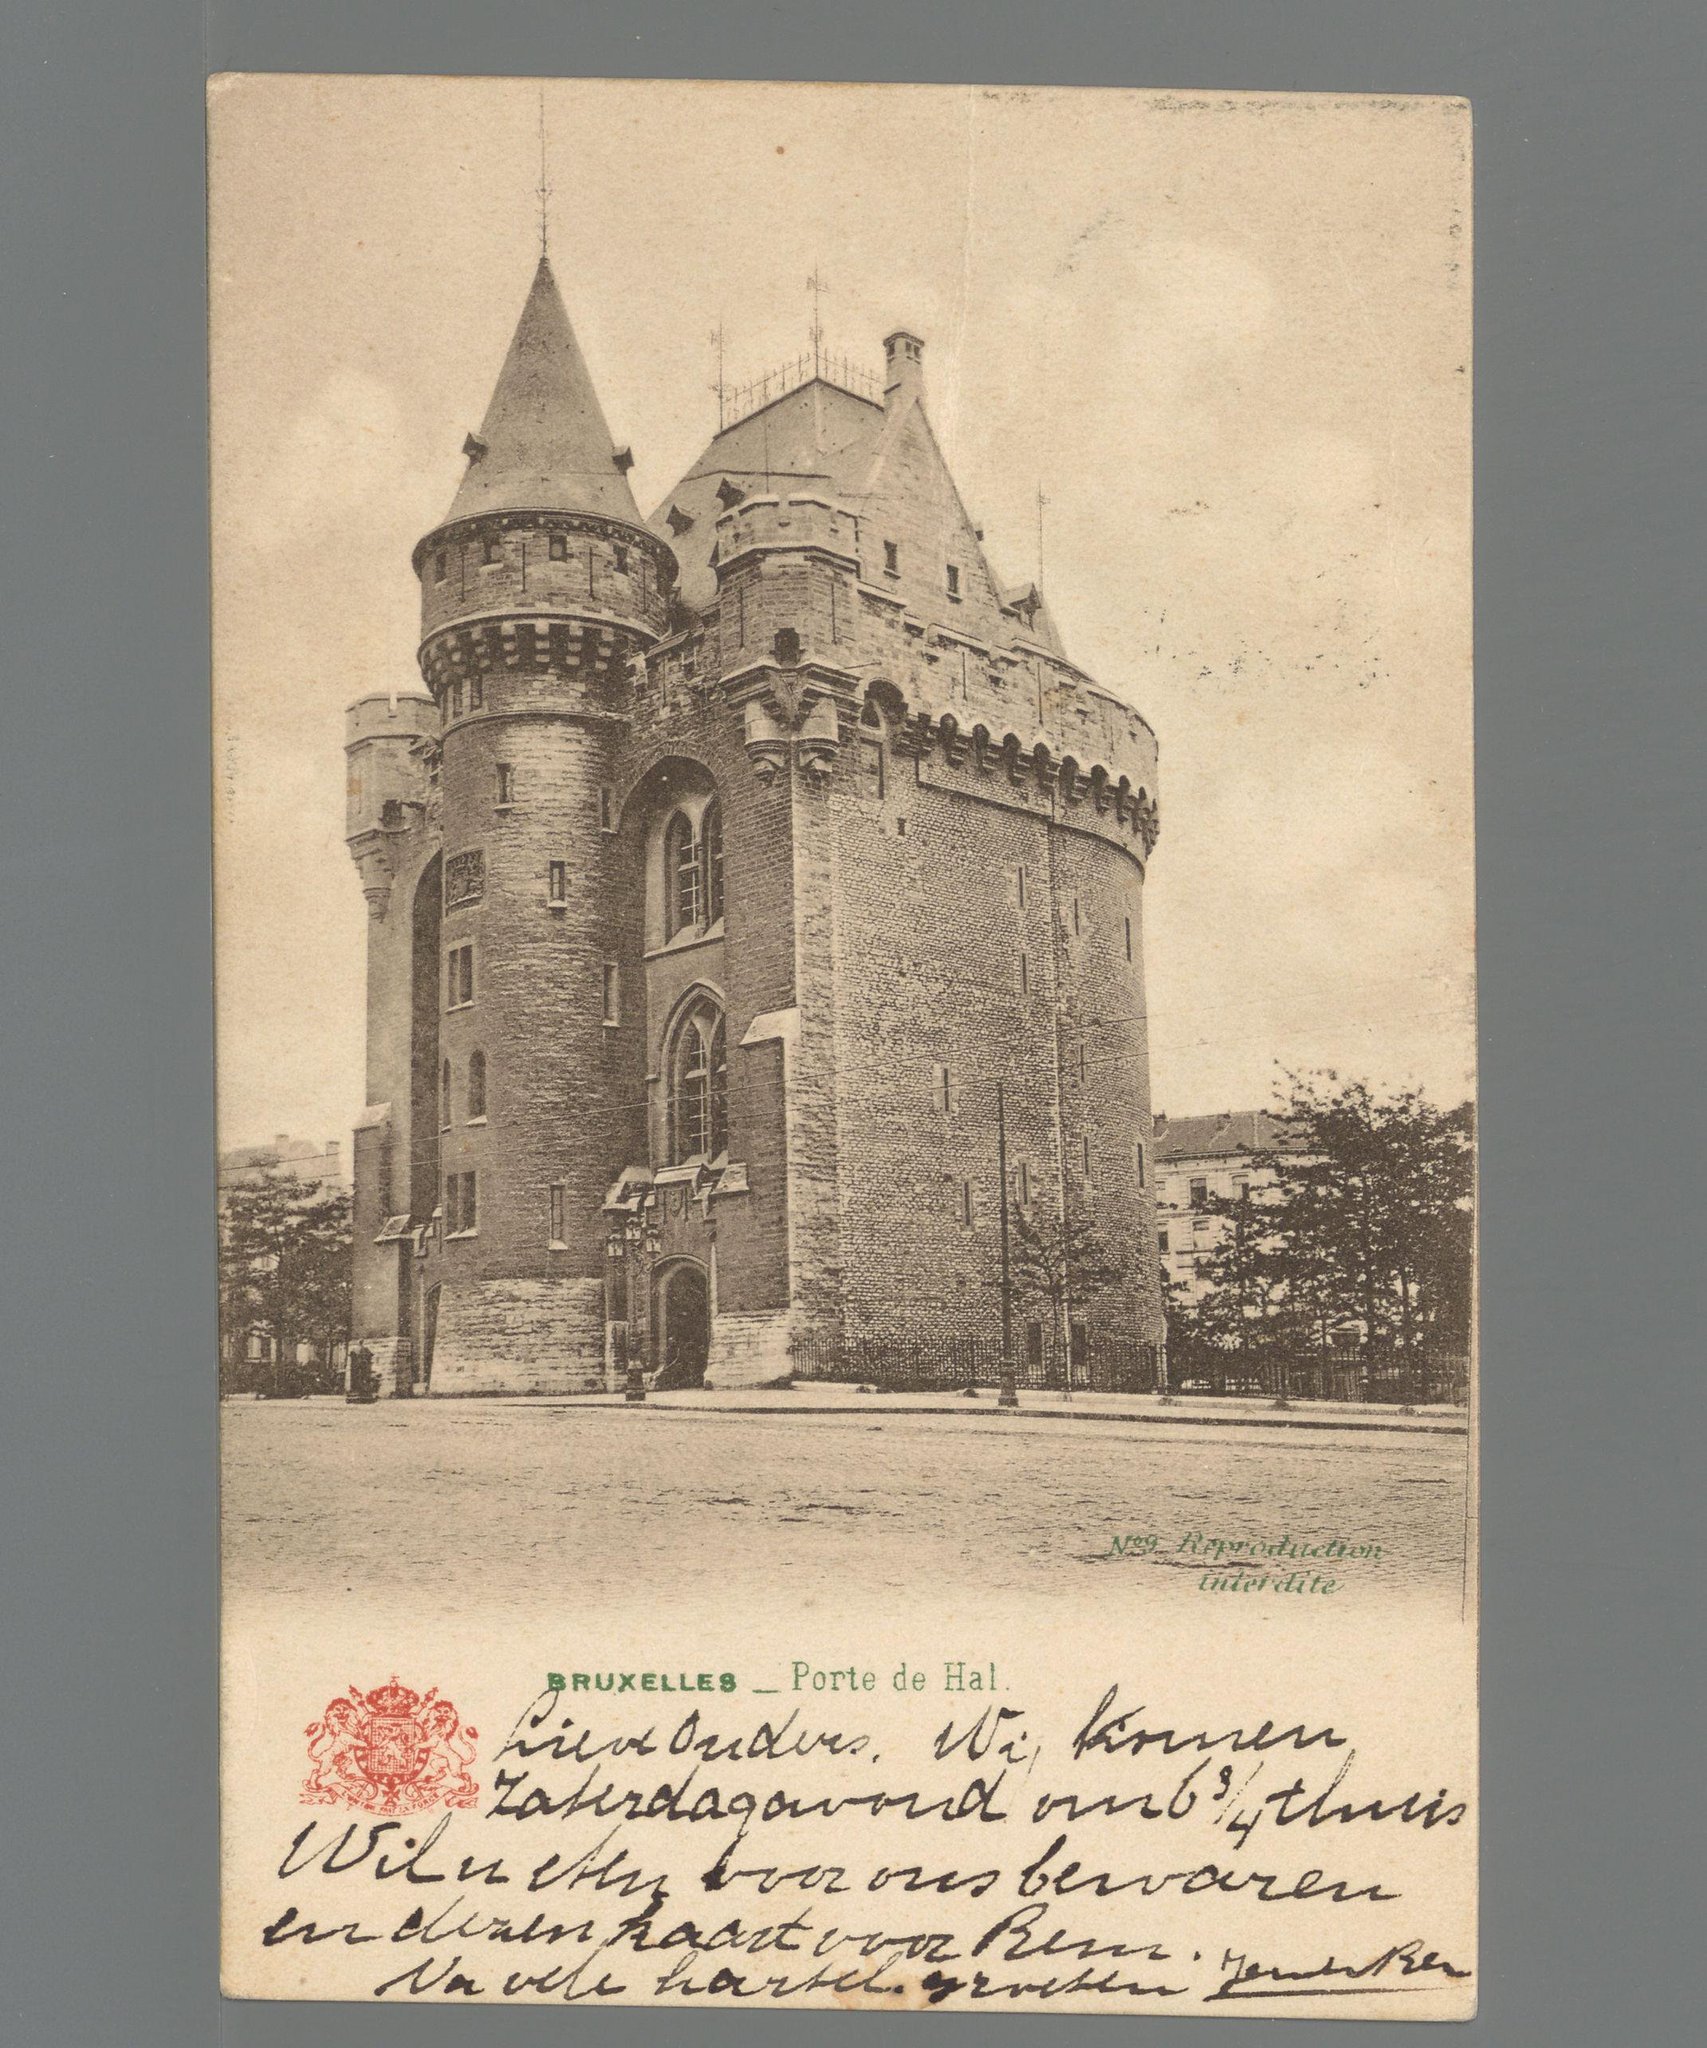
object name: photomechanical print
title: Bruxelles. Porte de Hal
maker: Anonymous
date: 1903-1906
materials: cardboard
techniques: photograph, writing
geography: brussels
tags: square, place, circus, etc., city-gate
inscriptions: poststempel, verso, gestempeld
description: Onder staat: No. 9 Reproduction interdite.